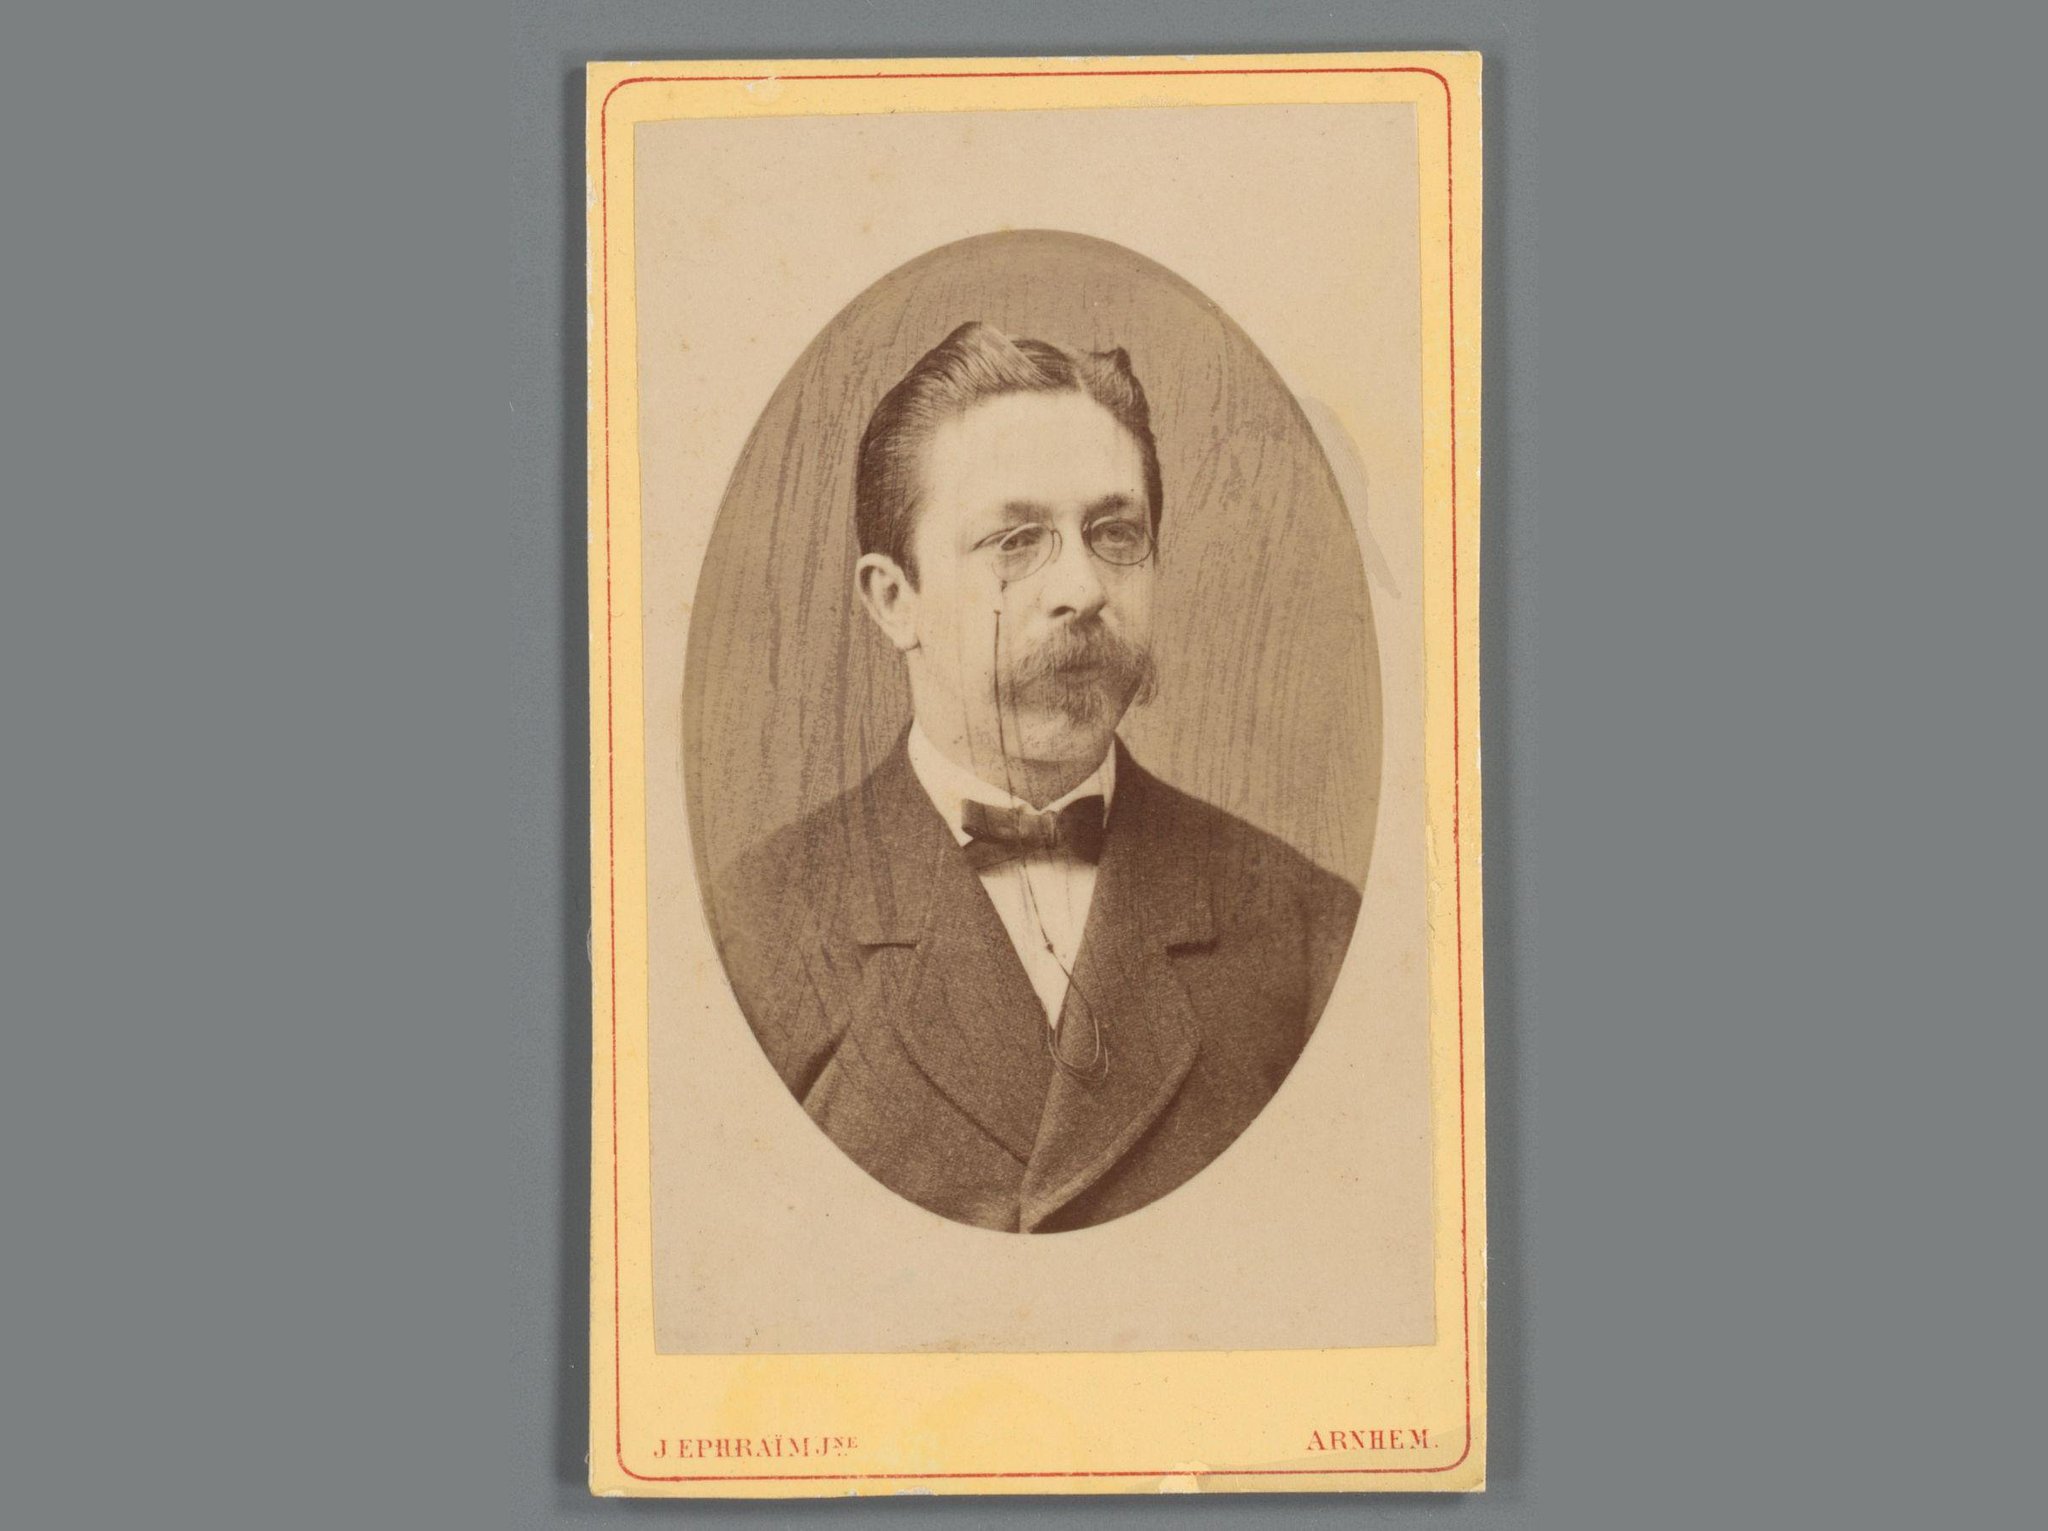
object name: carte de visite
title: Portret van een onbekende man met bril uit de familie en de kring van Eugene van Delden en Belle van Delden-Denninghof Stelling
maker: johannes ephraim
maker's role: fotograaf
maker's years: 1838-1921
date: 1880-1890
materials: cardboard, paper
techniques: albumen print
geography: arnhem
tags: eyeglasses, spectacles, historical persons not known by name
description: Portret uit de kring van Eugene van Delden (Hartapoera, 1865 - Den Haag, 1954) en Belle van Delden-Denninghof Stelling (Batavia, 1870 - Den Haag, 1947).